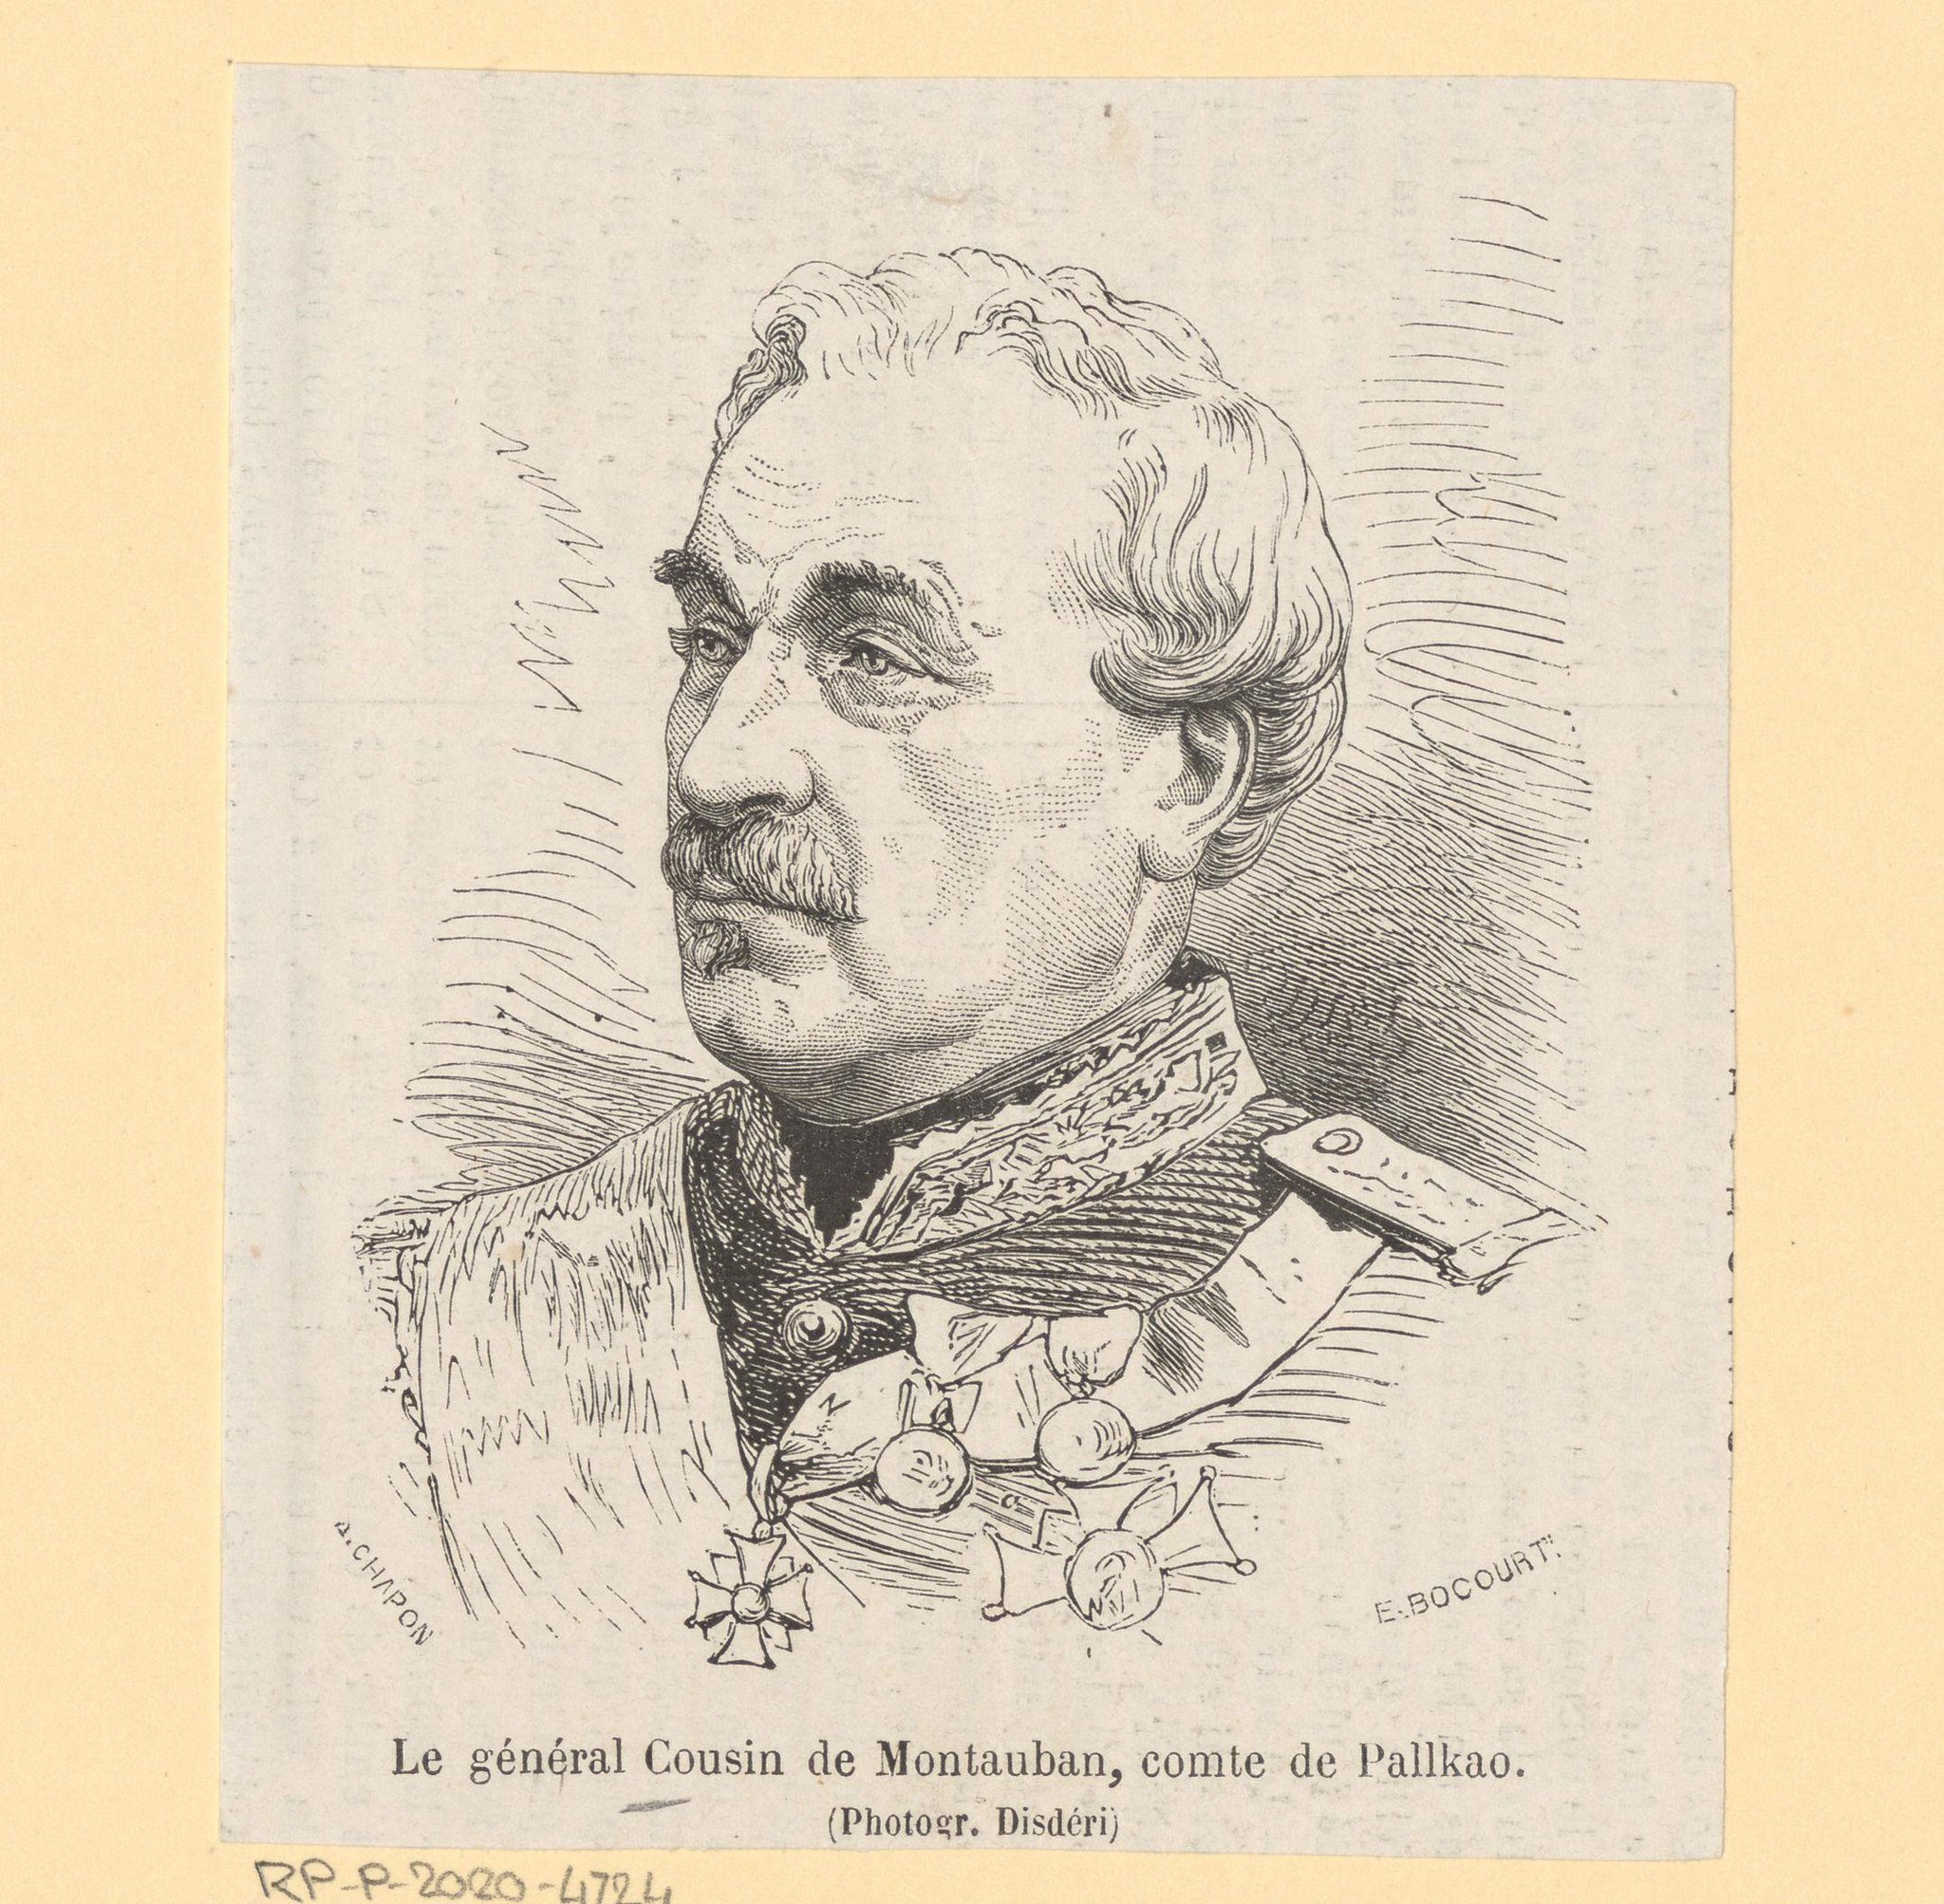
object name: print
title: Portret van Charles Cousin-Montauban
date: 1861-1882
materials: paper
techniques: letterpress printing, engraving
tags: paris, politician, historical persons